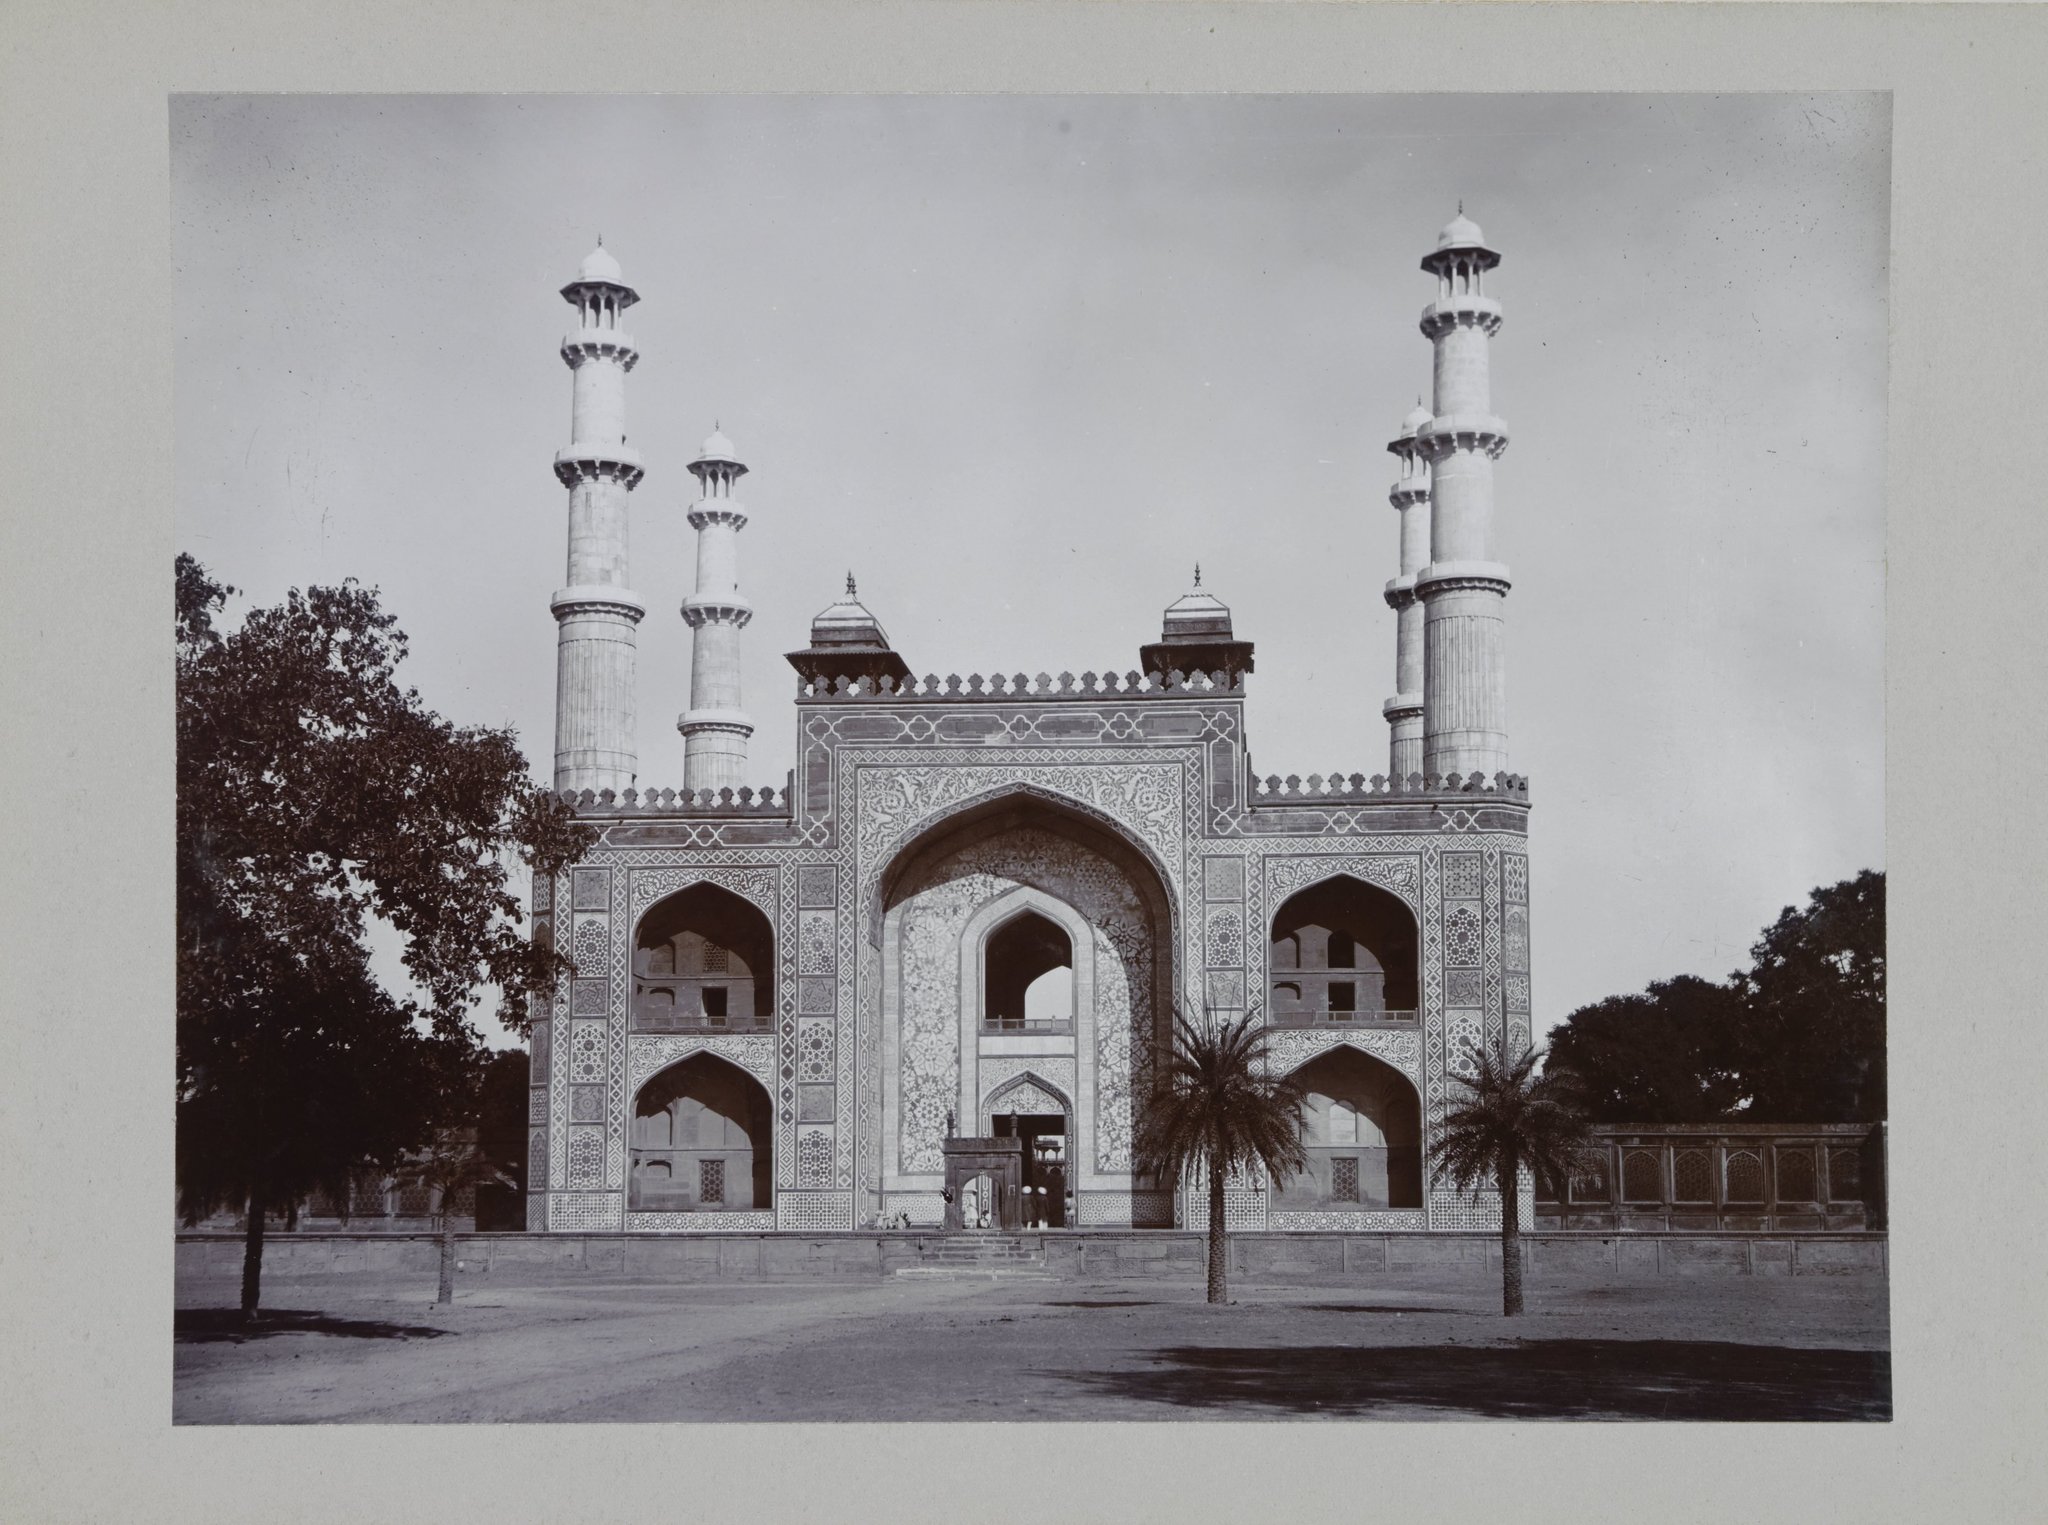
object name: photograph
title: Entrance to the Itimad ud-Daulah's Tomb, Agra, Uttar Pradesh, India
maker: Anonymous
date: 1895-1915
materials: cardboard, paper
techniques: gelatin silver print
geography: agra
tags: agra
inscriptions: annotation: ‘51. Ingang v/'t Mausoleum van I'timad bij Agra.’